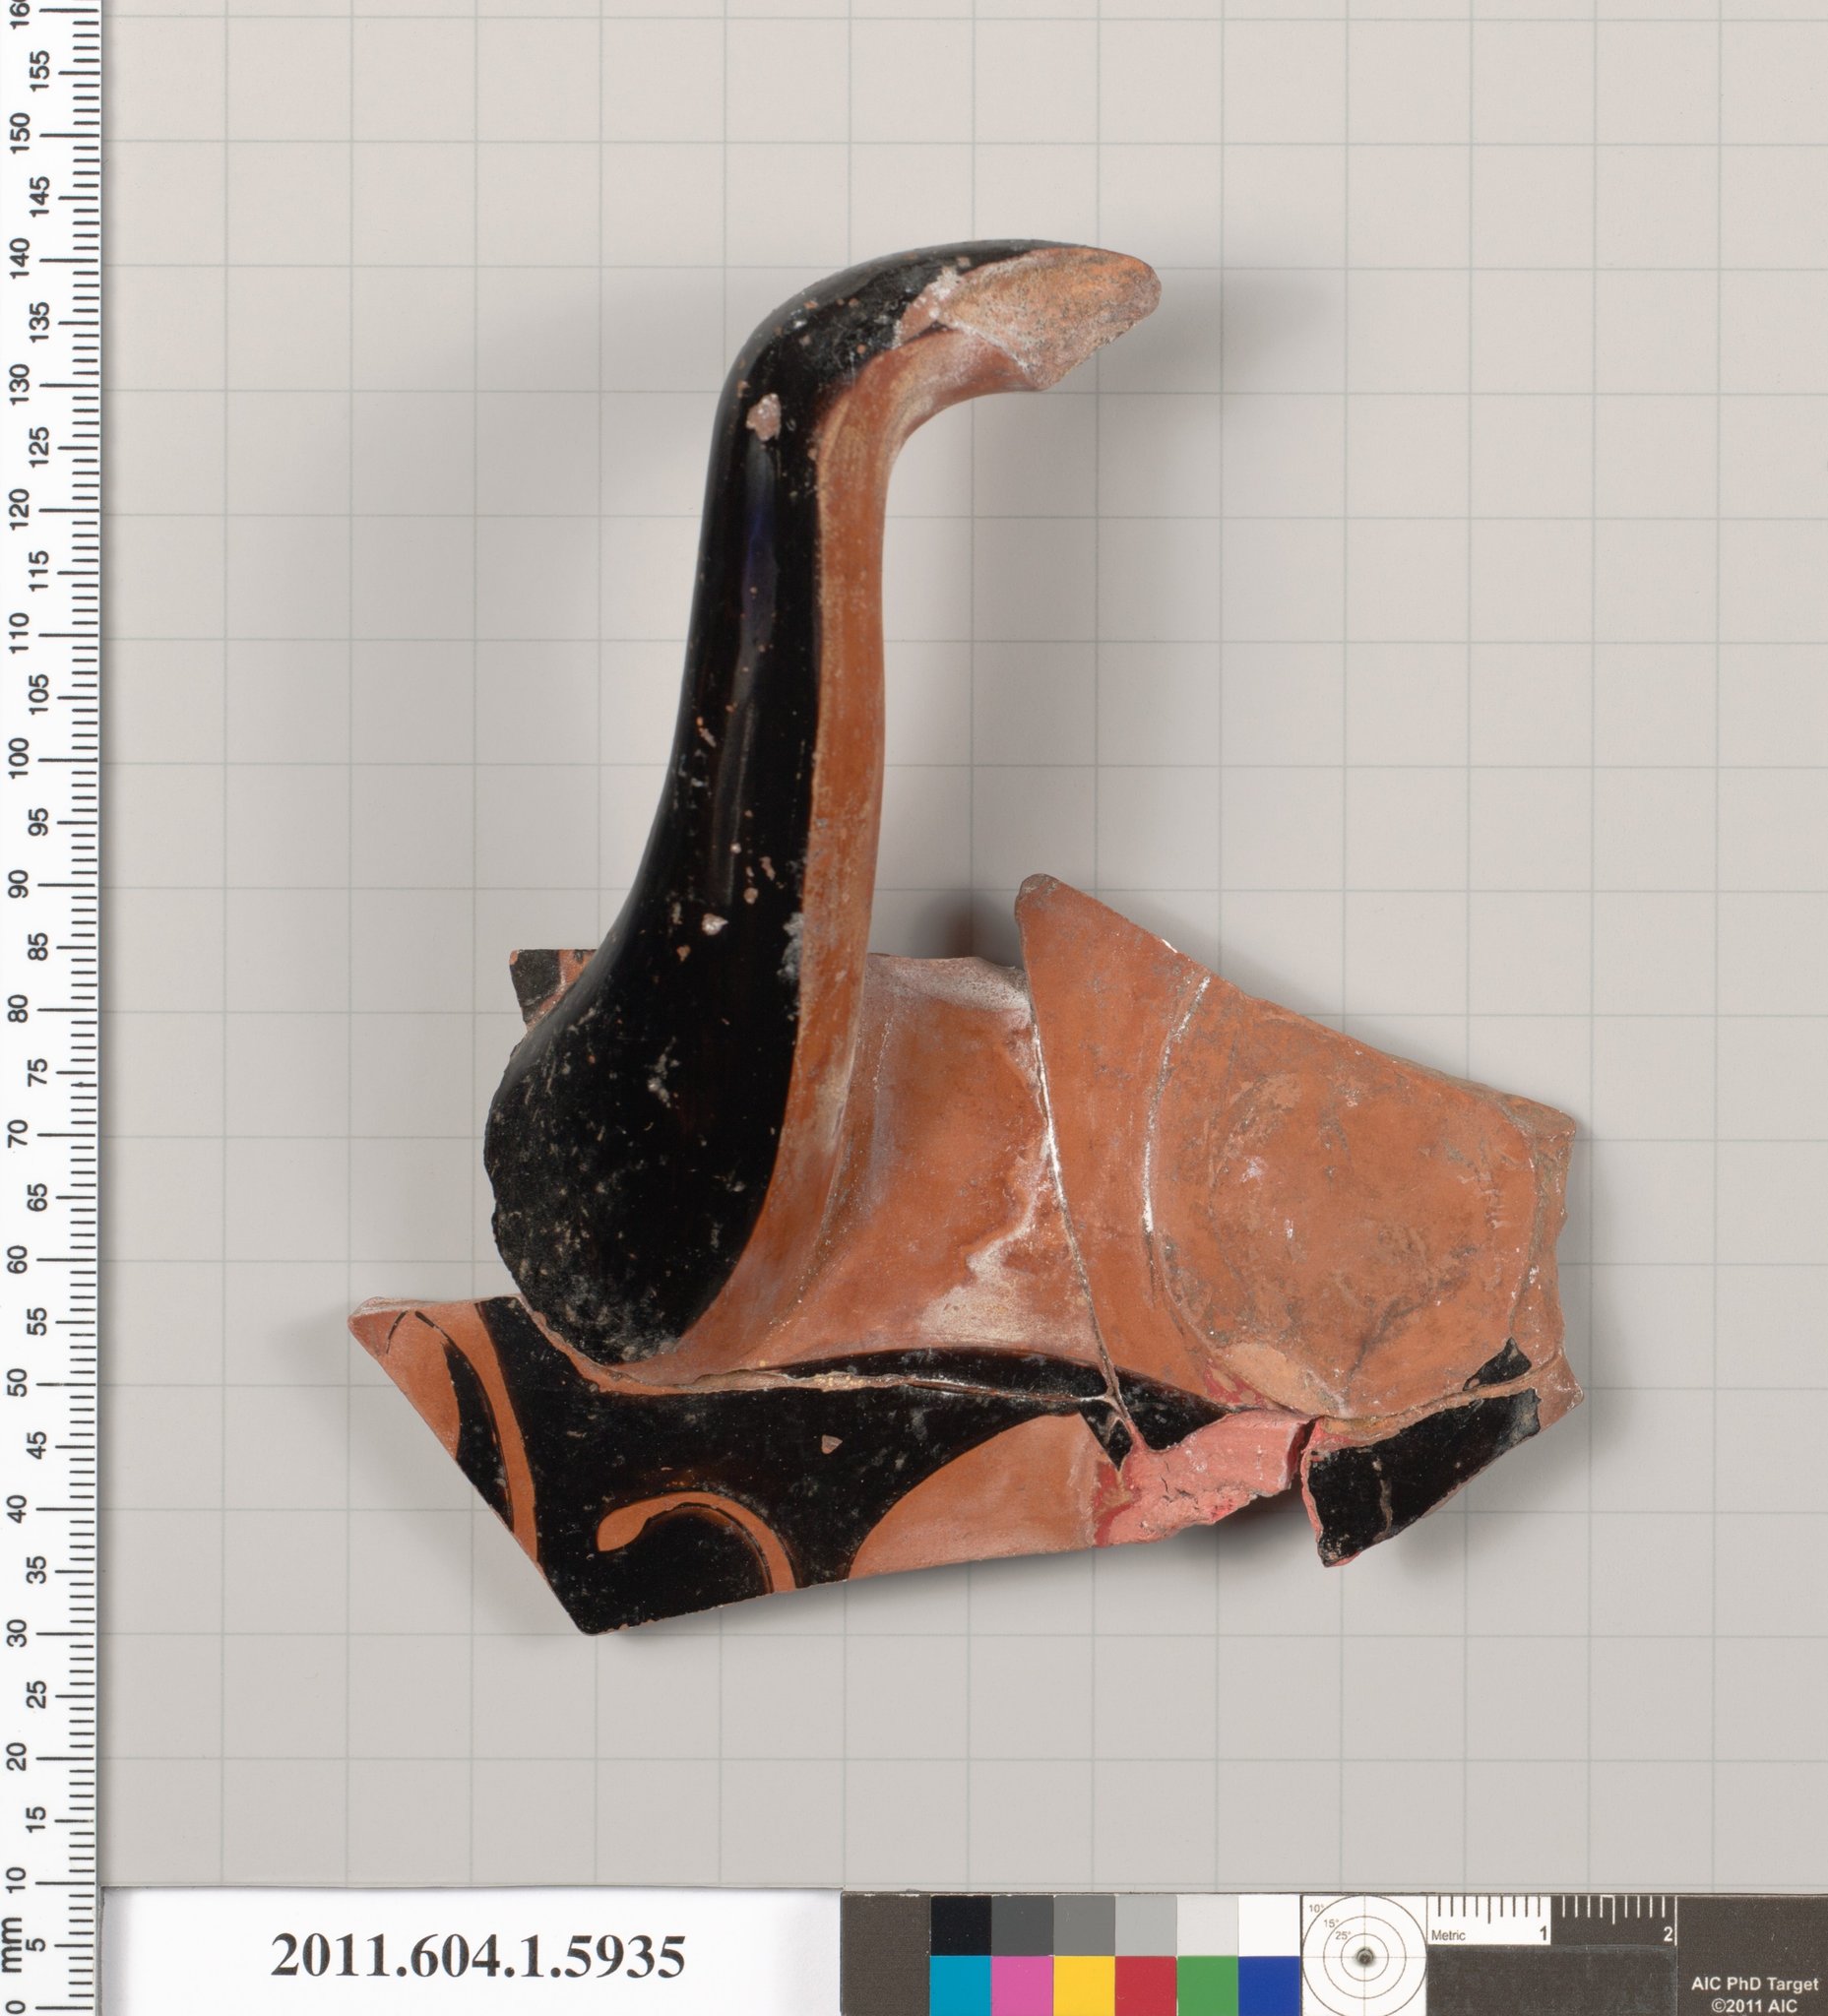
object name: kylix fragment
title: Terracotta fragment of a kylix (drinking cup)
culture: greek, attic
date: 520-510 BCE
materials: terracotta